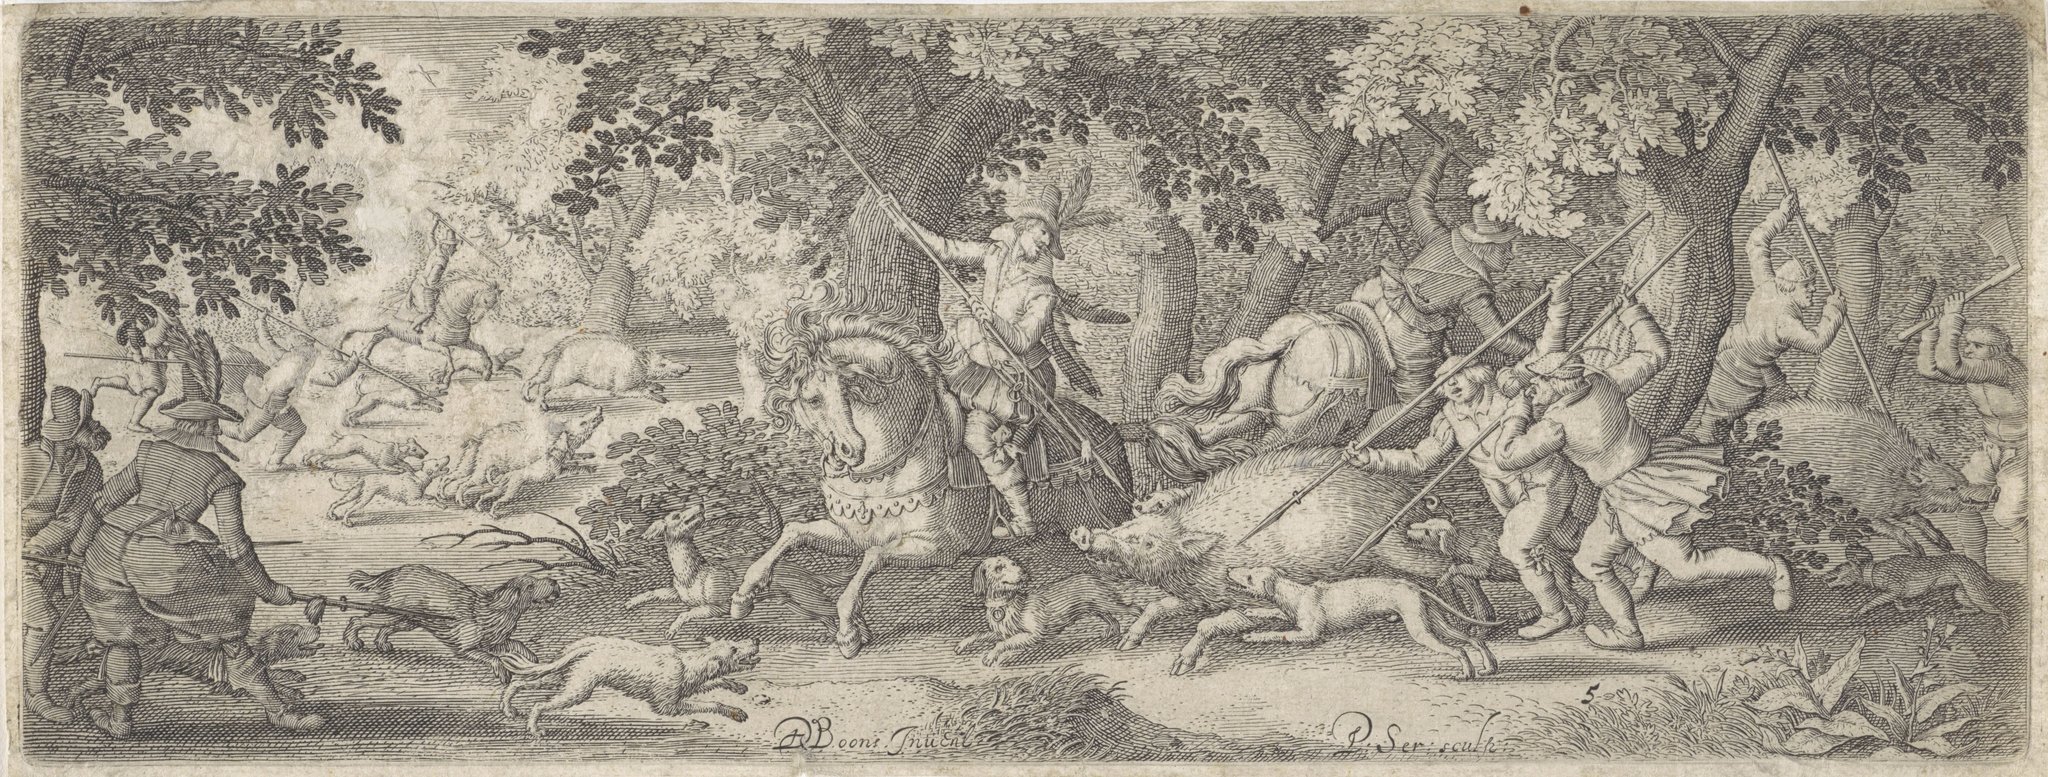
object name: print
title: Jachttaferelen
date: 1612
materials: paper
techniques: engraving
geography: amsterdam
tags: hunting, chase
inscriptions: collector's mark: Lugt 2228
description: Mannen te paard en te voet jagen met speren en een bijl op vier zwijnen. Honden drijven de beesten verder op. Een van de honden ligt gewond of dood op de grond.